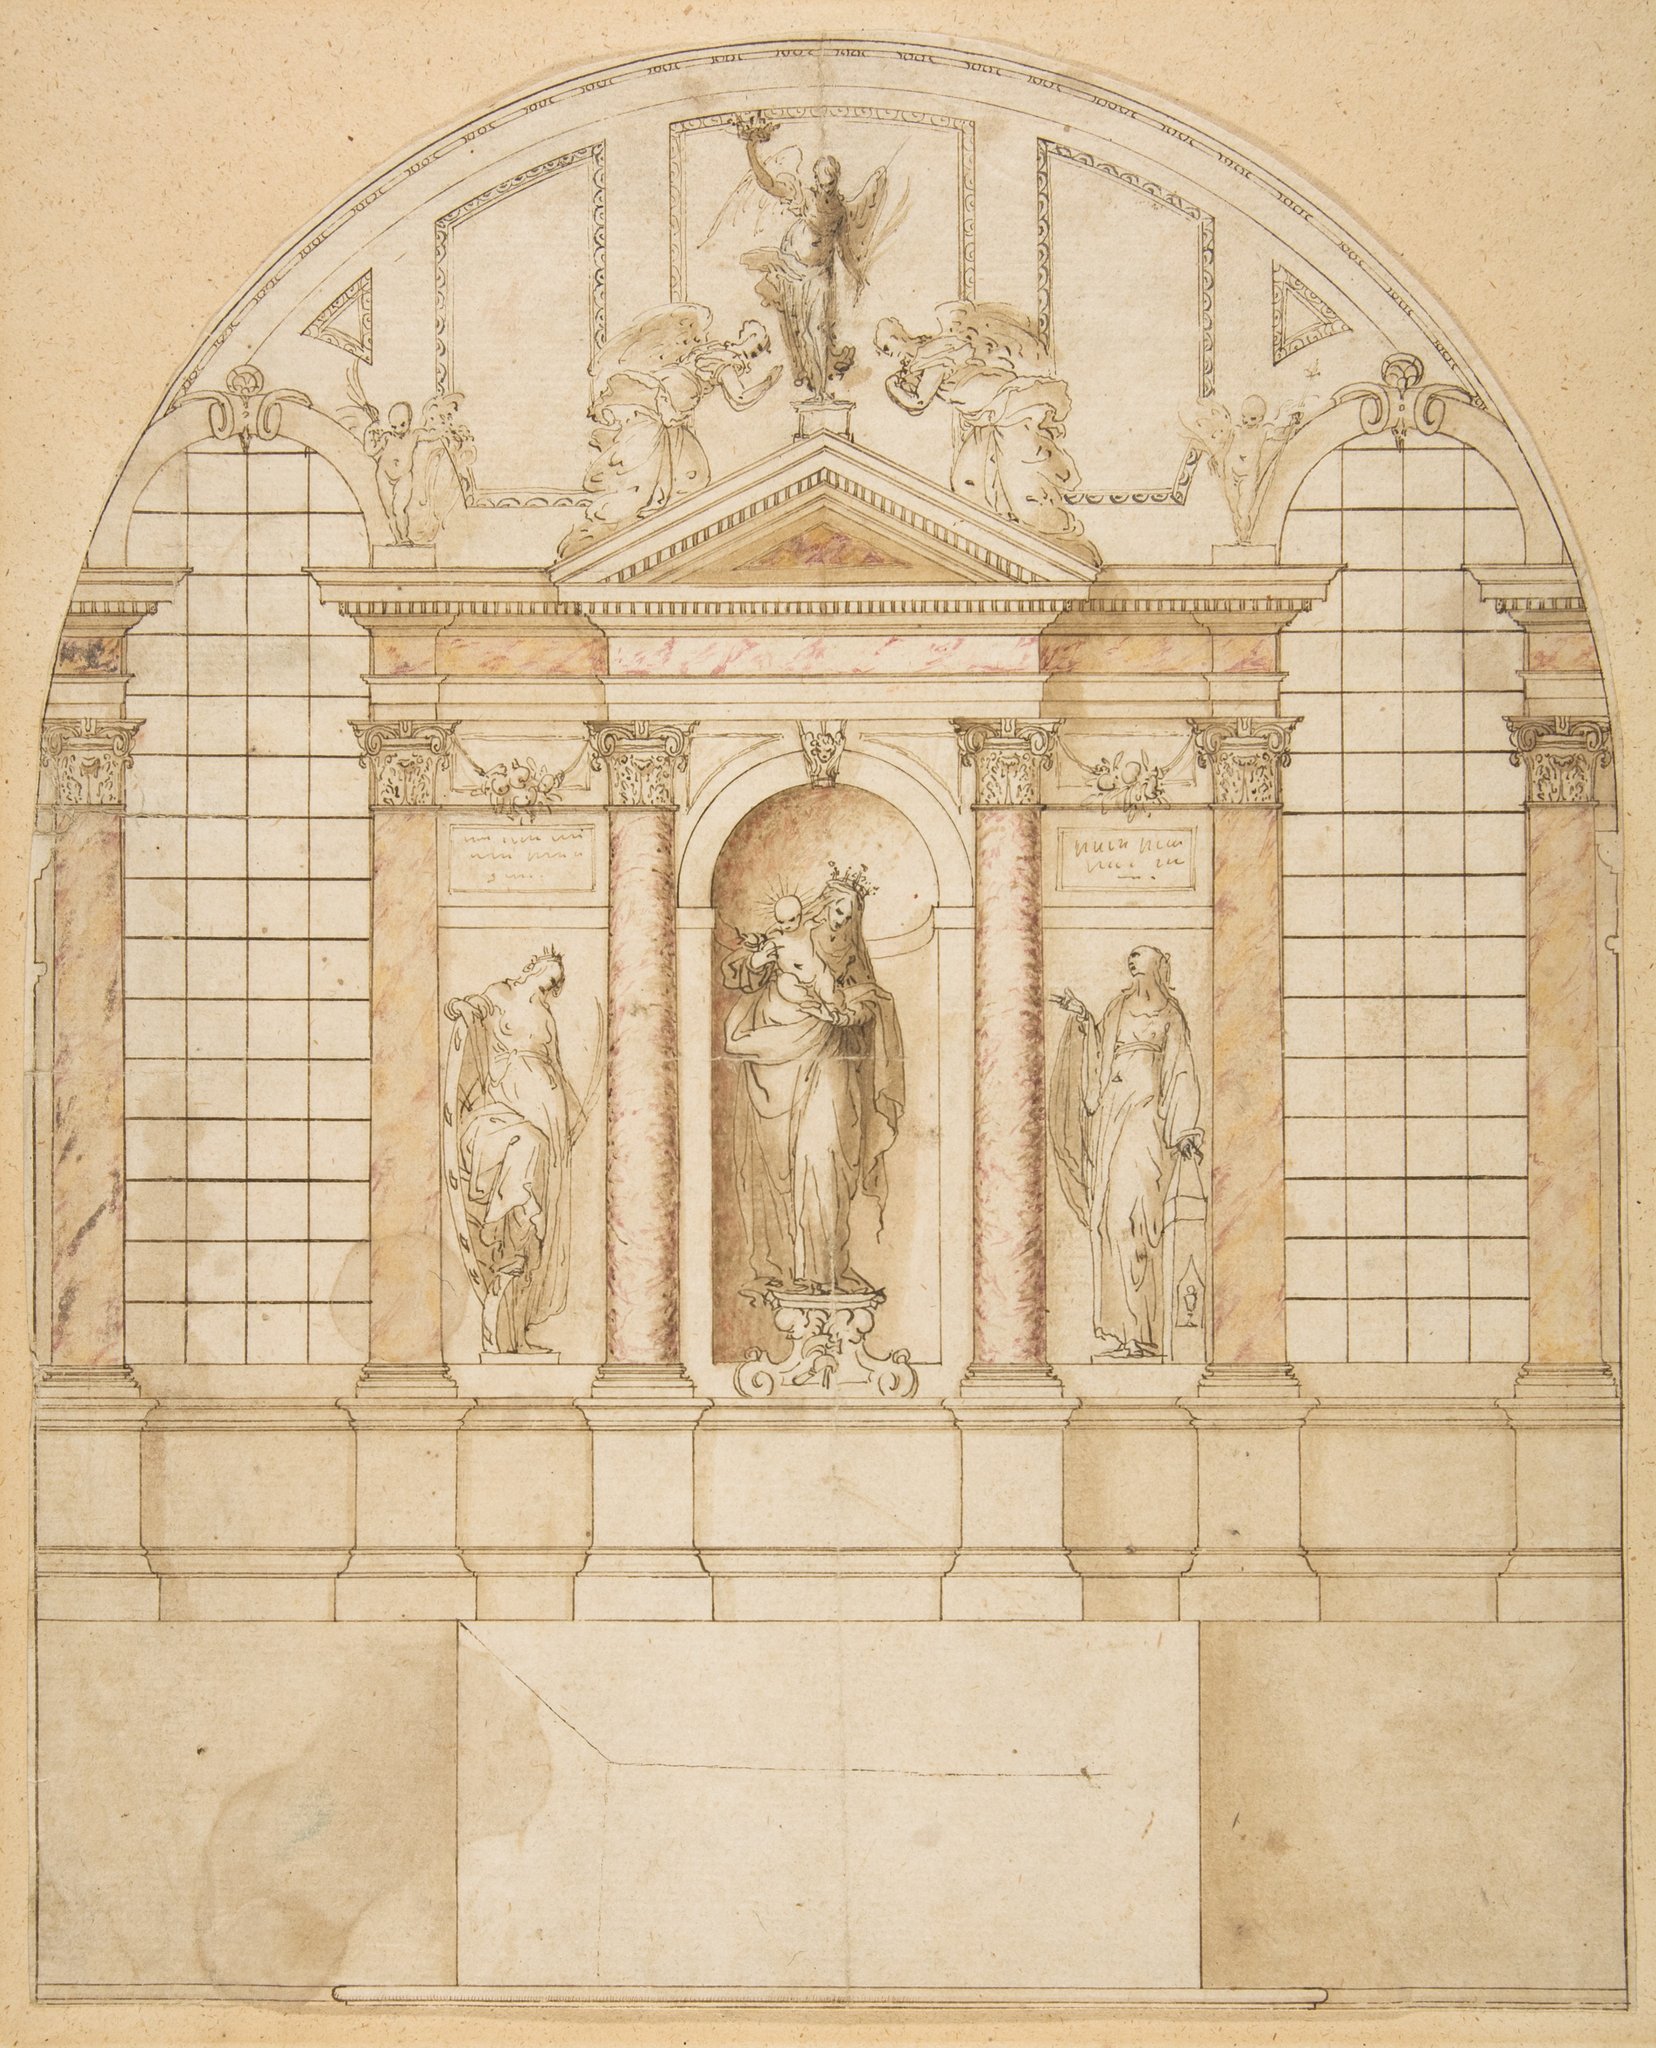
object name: drawing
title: Design for an Altarpiece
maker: anonymous, french, 18th century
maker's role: artist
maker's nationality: french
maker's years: 1700-1800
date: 1667-1733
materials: ink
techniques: brush, pen, wash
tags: madonna and child